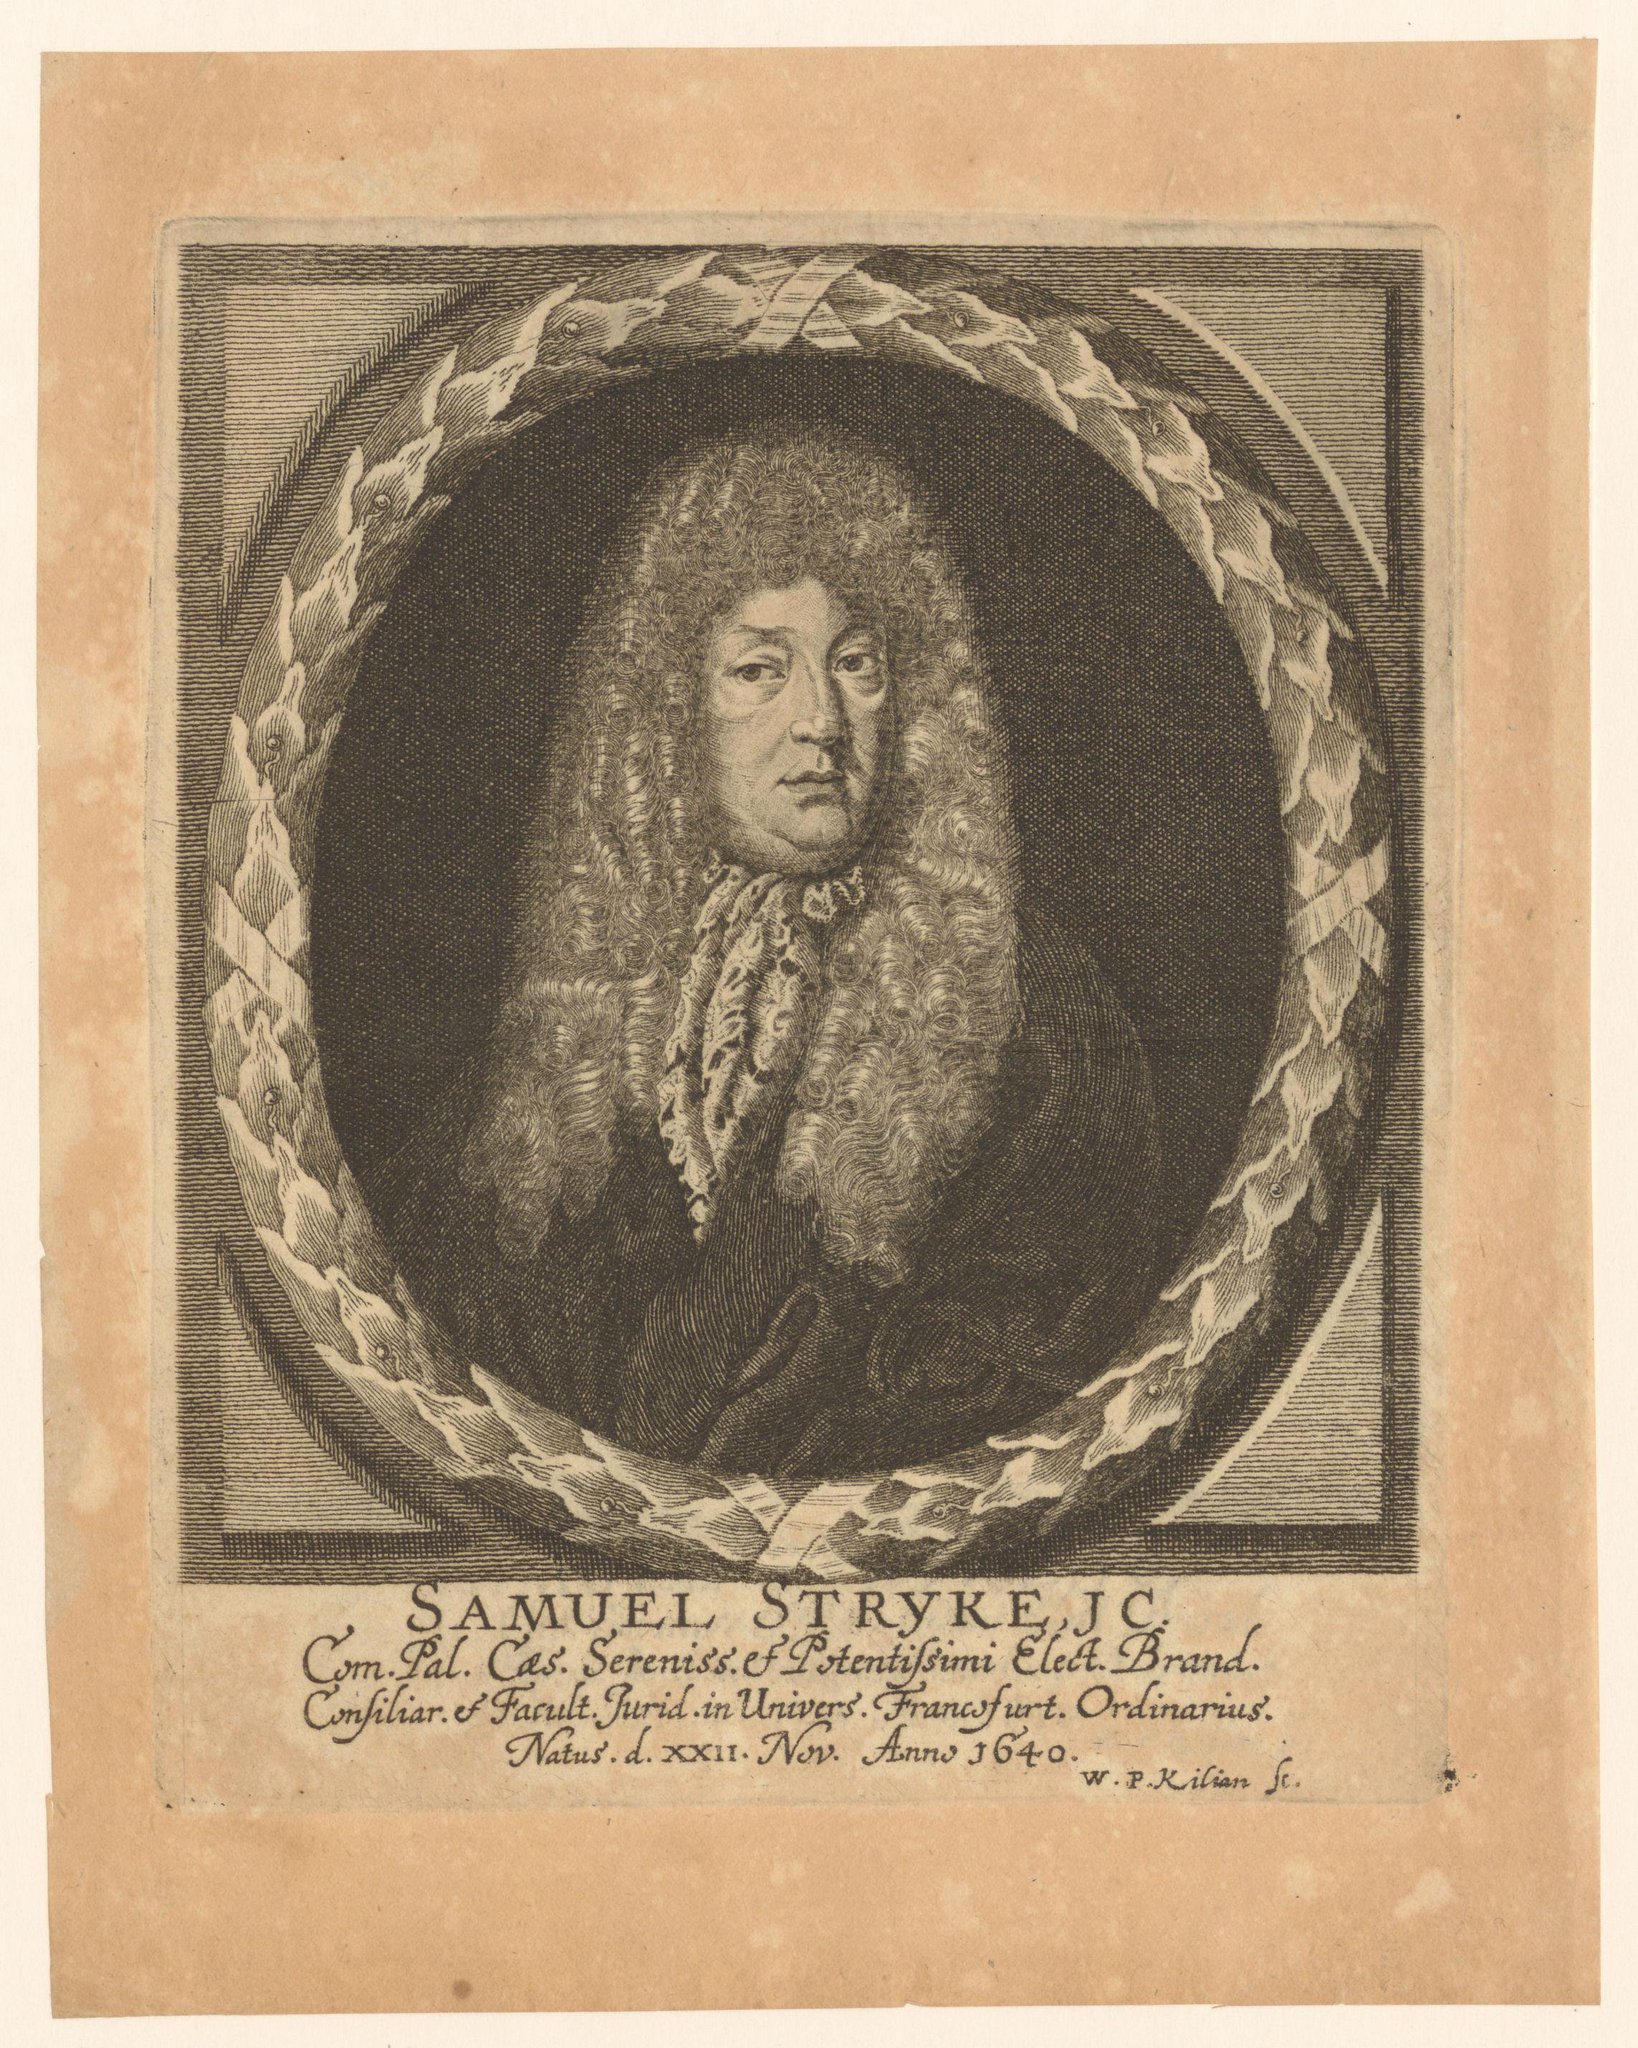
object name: print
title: Portret van Samuel Stryk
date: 1669-1690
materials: paper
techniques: engraving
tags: samuel stryk, historical persons, lawyer, attorney at law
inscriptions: collector's mark: Lugt 2228